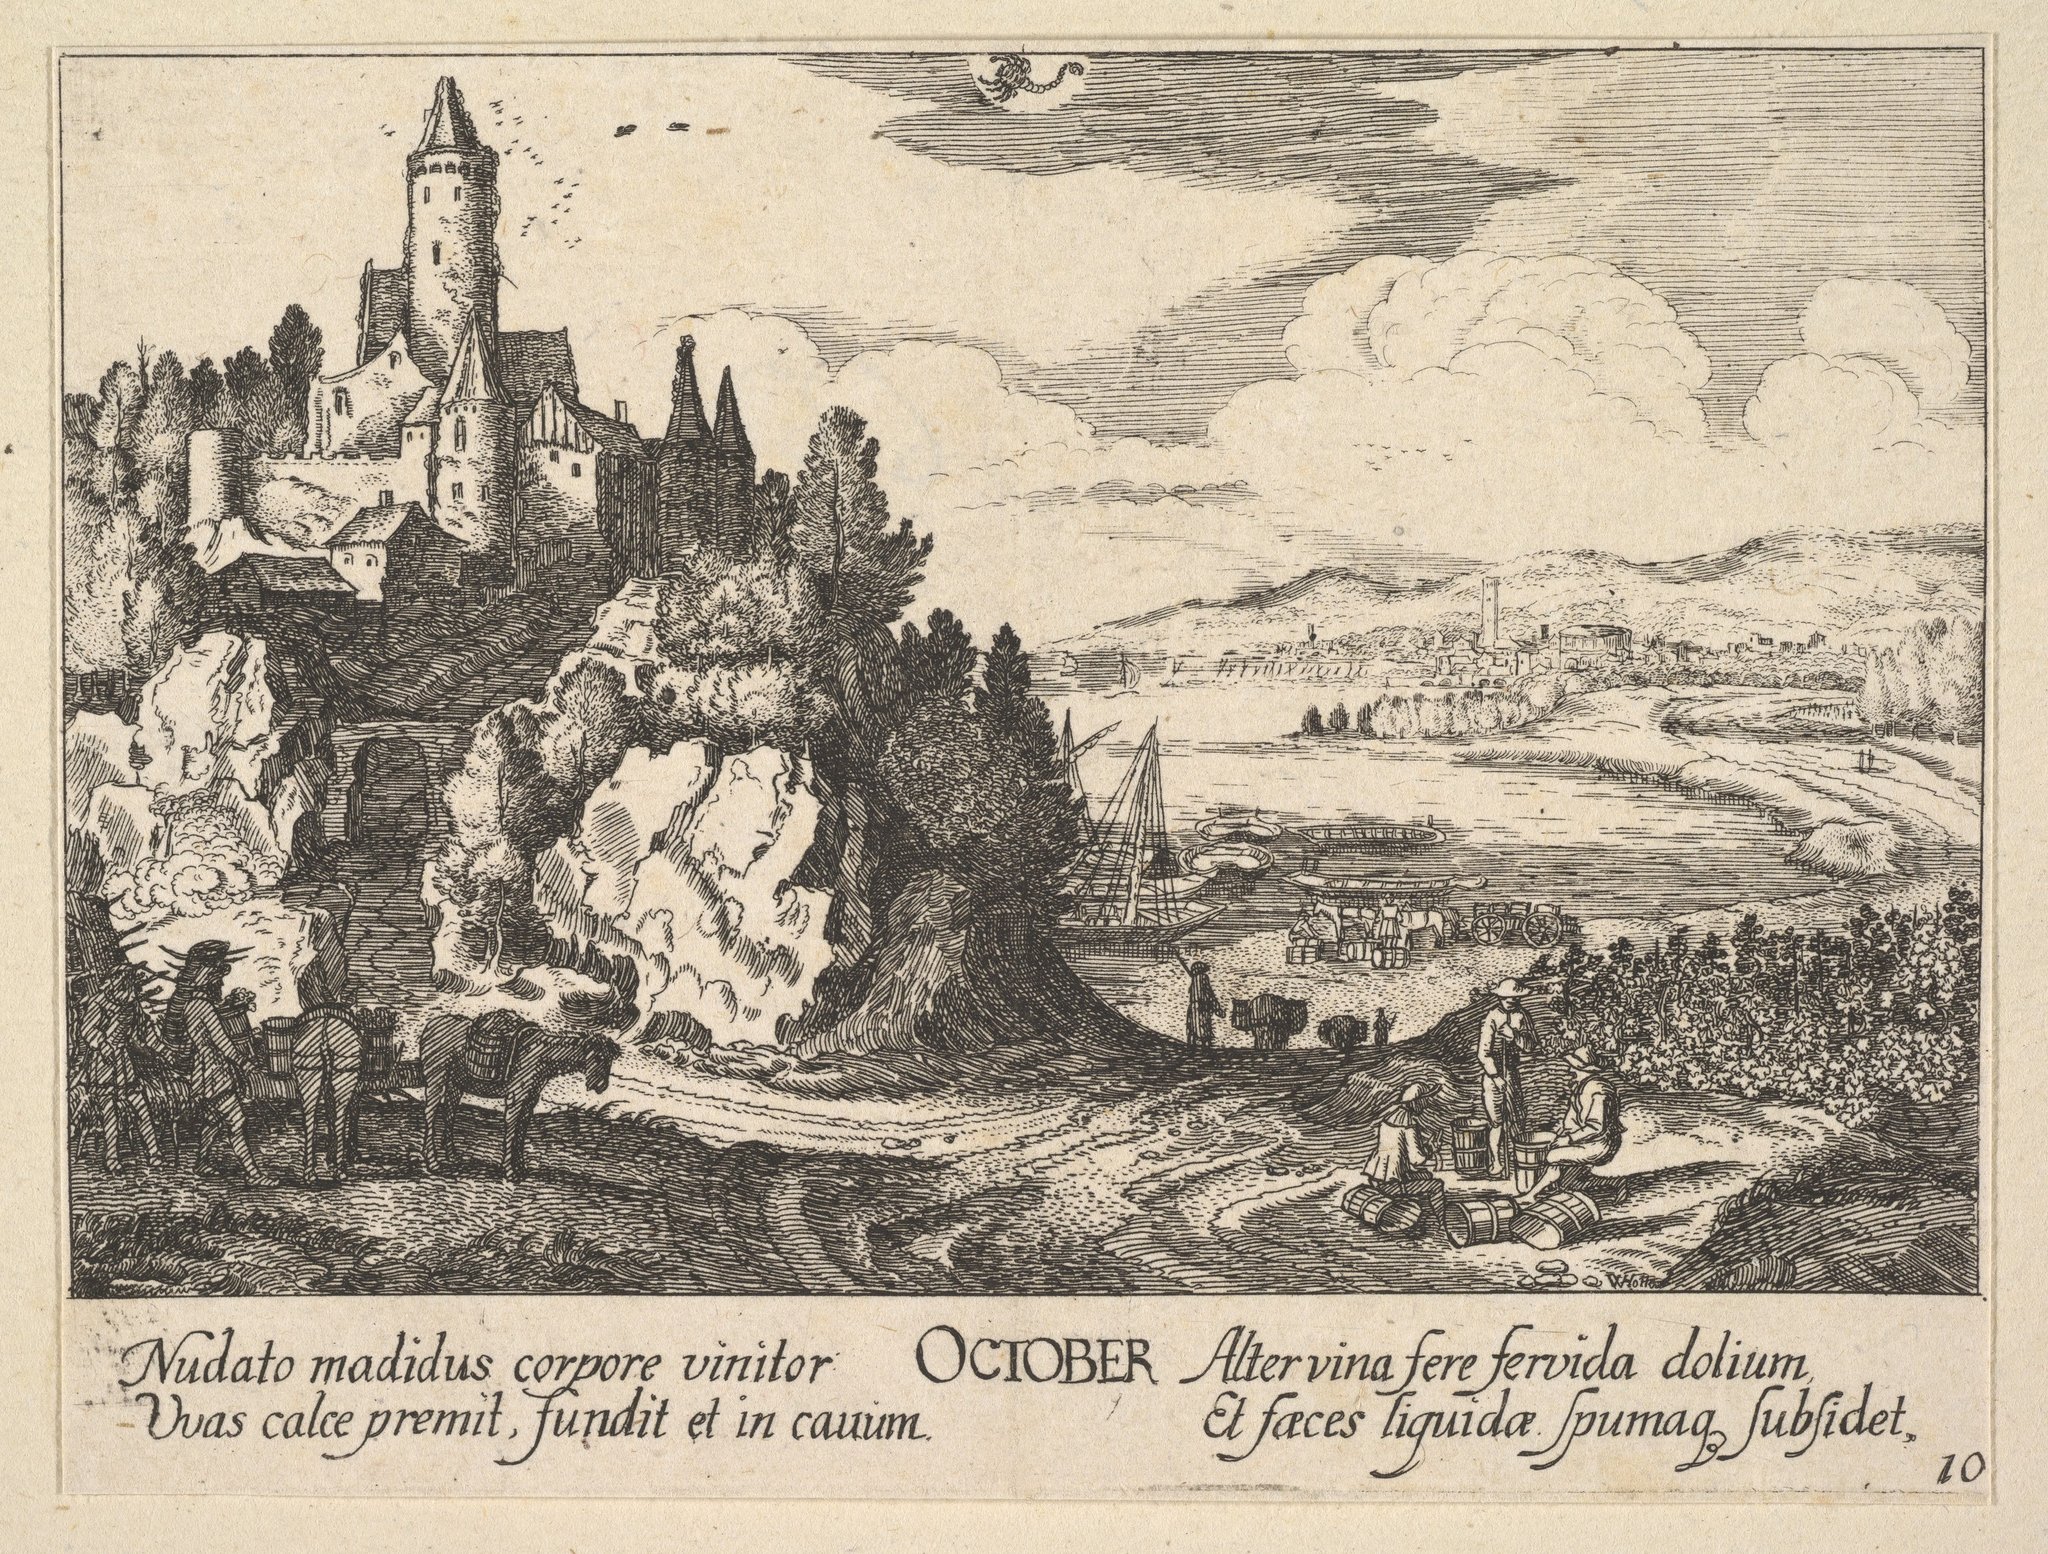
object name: print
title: October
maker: wenceslaus hollar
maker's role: artist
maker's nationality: bohemian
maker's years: 1607-1677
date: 1628-1629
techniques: etching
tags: castles,men,horses,landscapes,trees